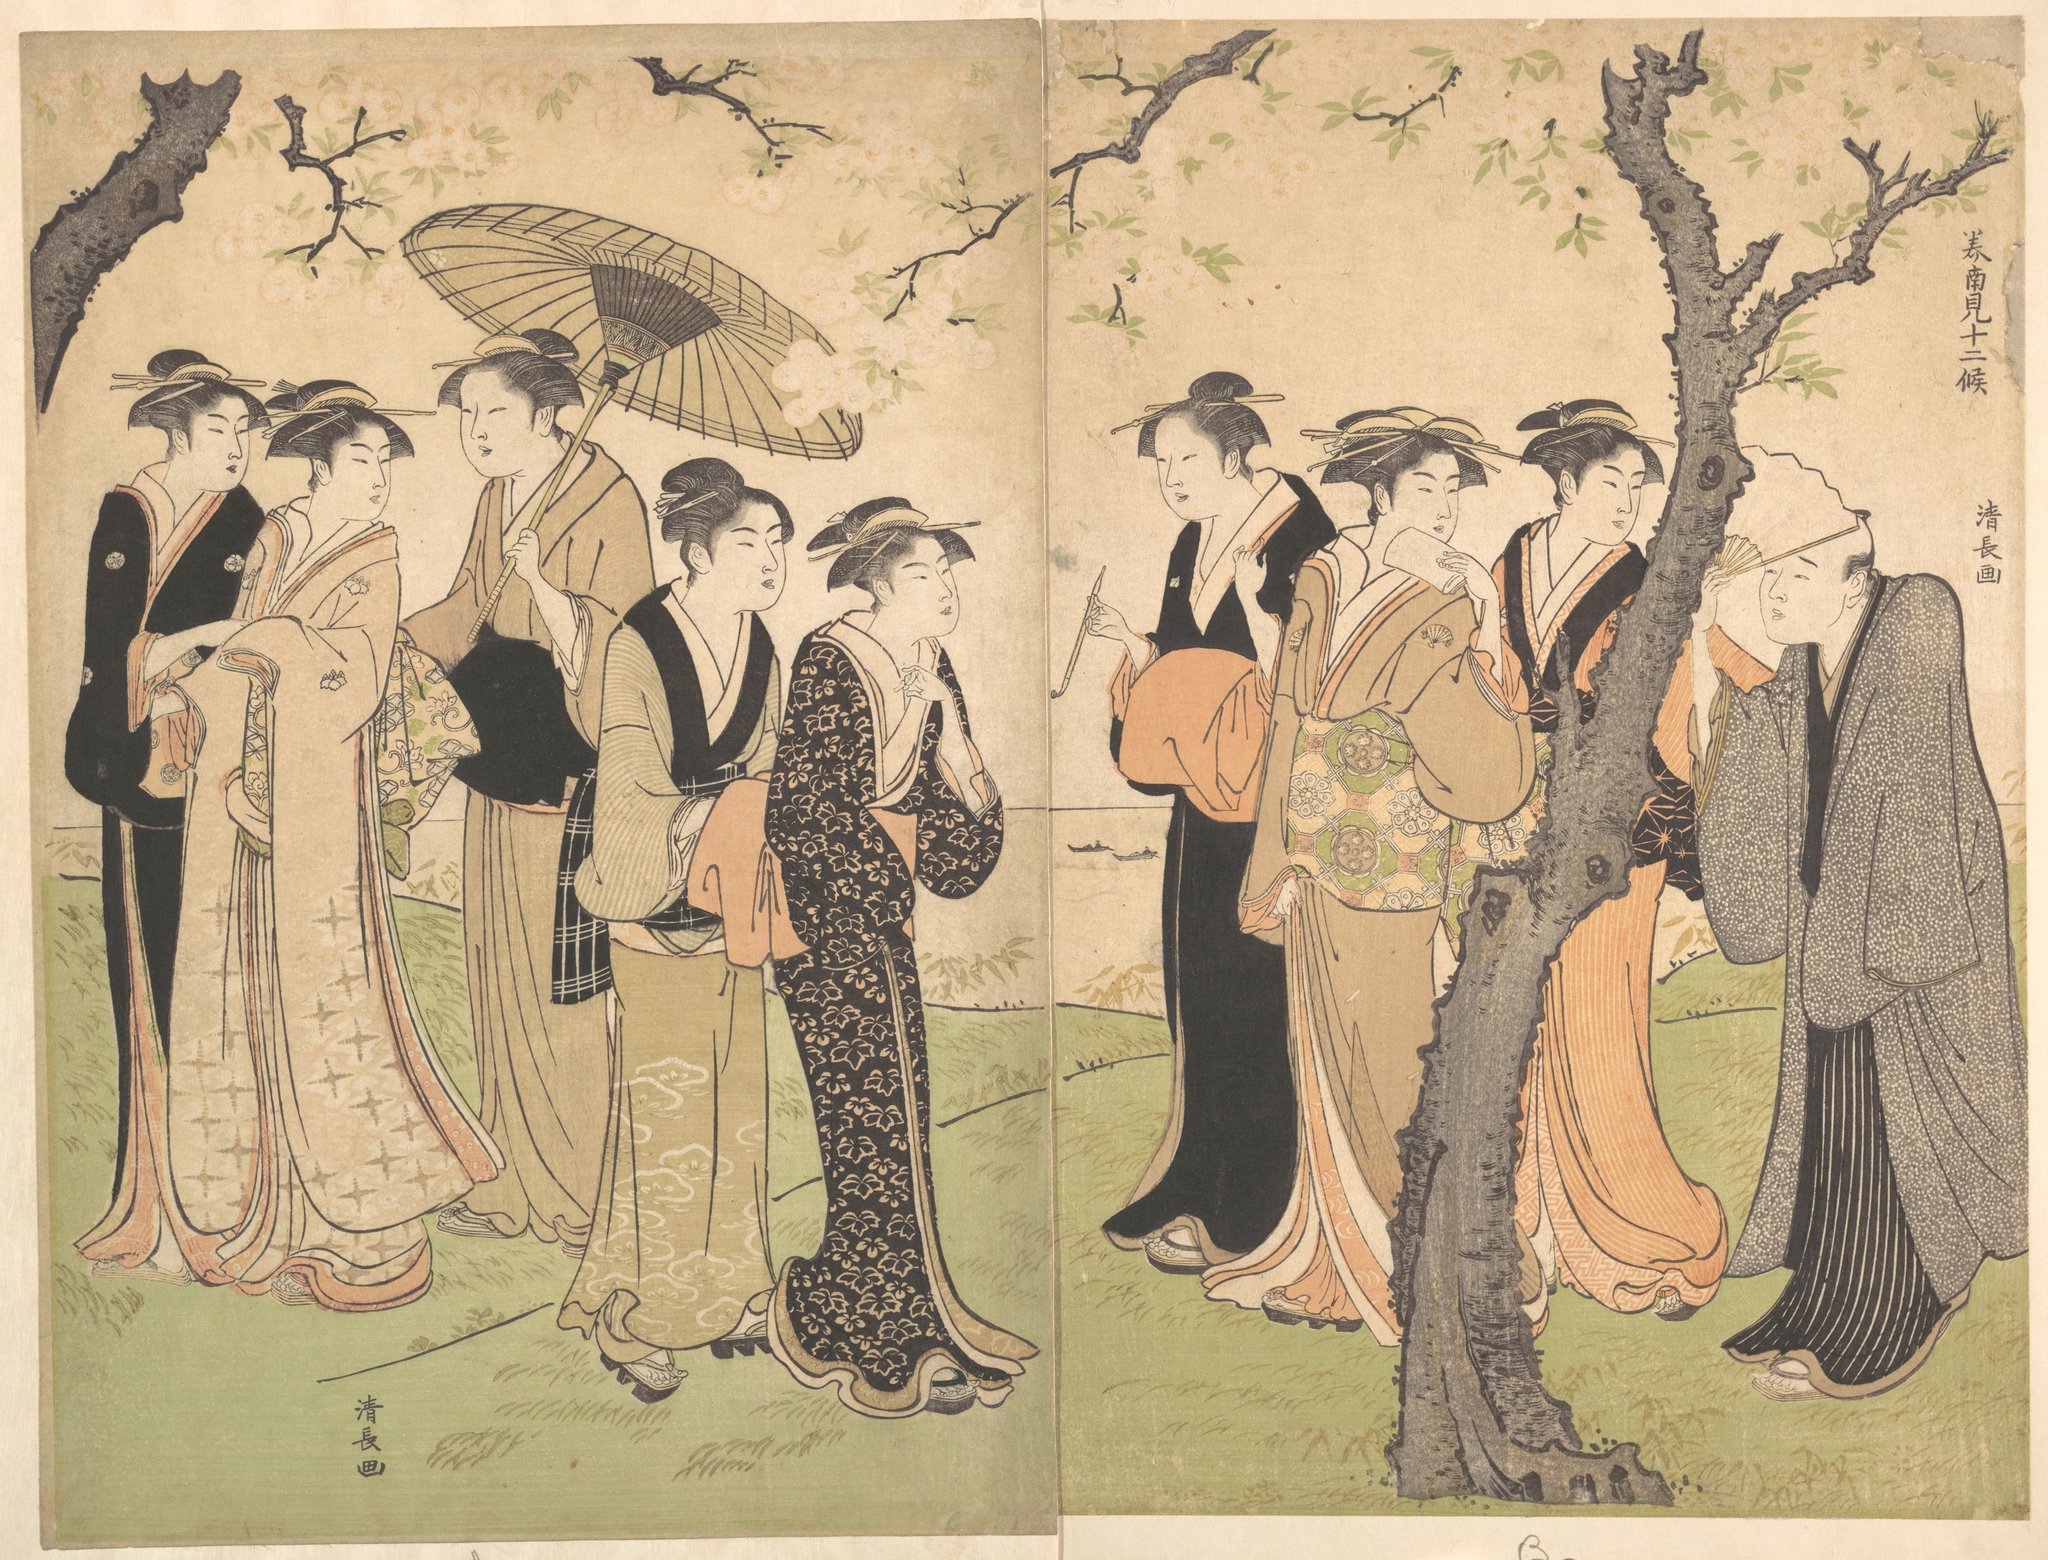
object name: woodblock print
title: Group of Six Geisha Under the Cherry Trees on Gotenyama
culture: japanese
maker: torii kiyonaga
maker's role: artist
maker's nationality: japanese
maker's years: 1752-1815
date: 1785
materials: ink, paper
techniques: woodblock print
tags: men,women,trees